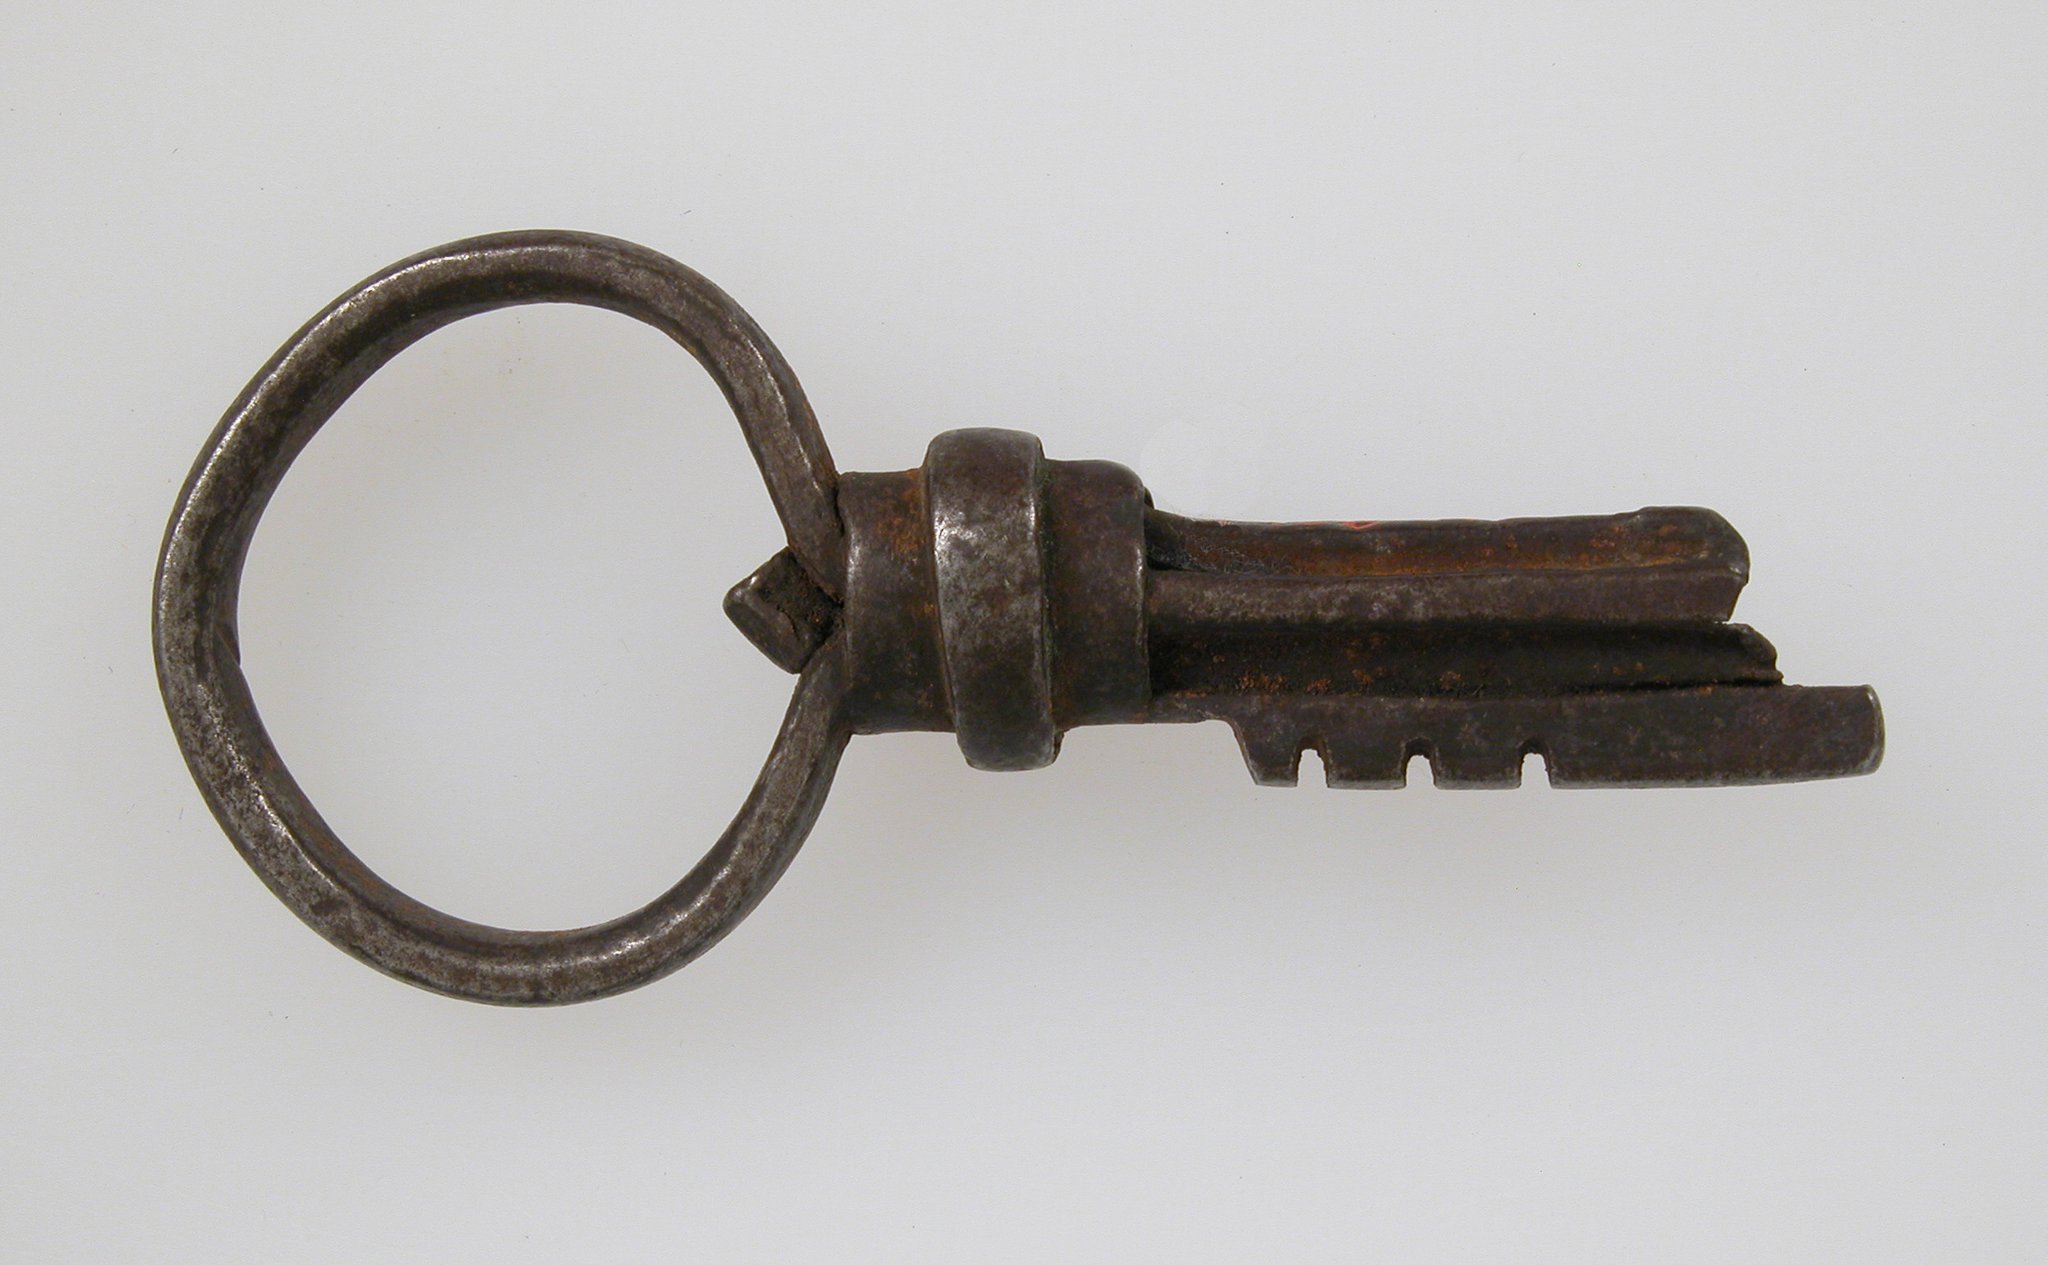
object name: key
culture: german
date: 1401-1500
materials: iron